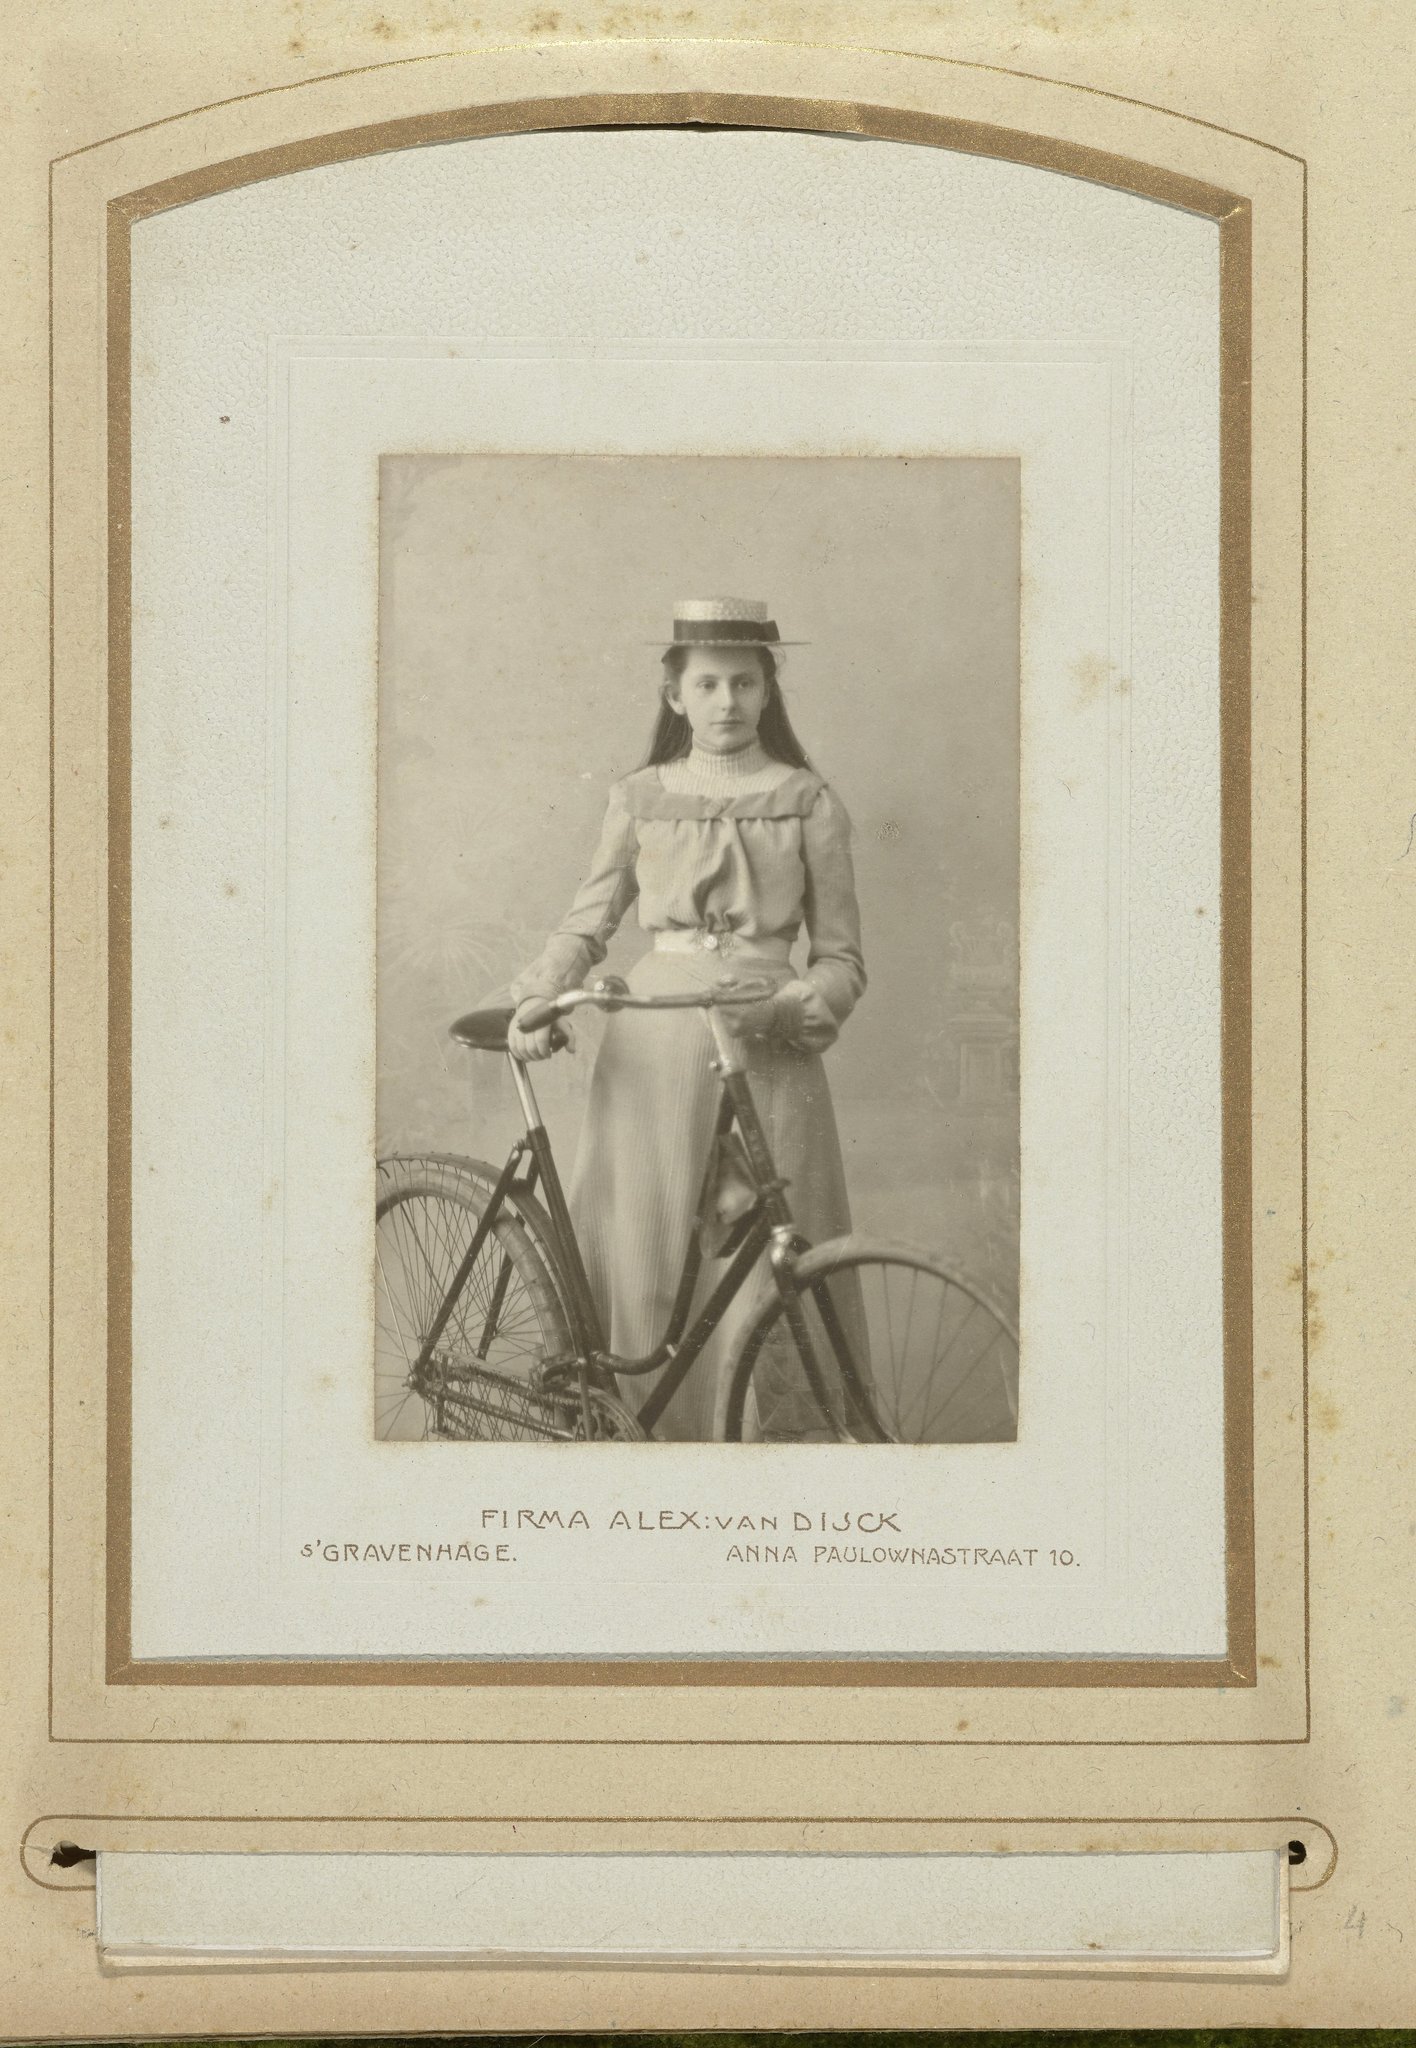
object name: photograph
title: Portret van jonge vrouw in jurk met damesfiets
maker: alex van dijck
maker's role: fotograaf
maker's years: 1866-1933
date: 1890-1910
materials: paper, photographic support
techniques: photography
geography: the hague